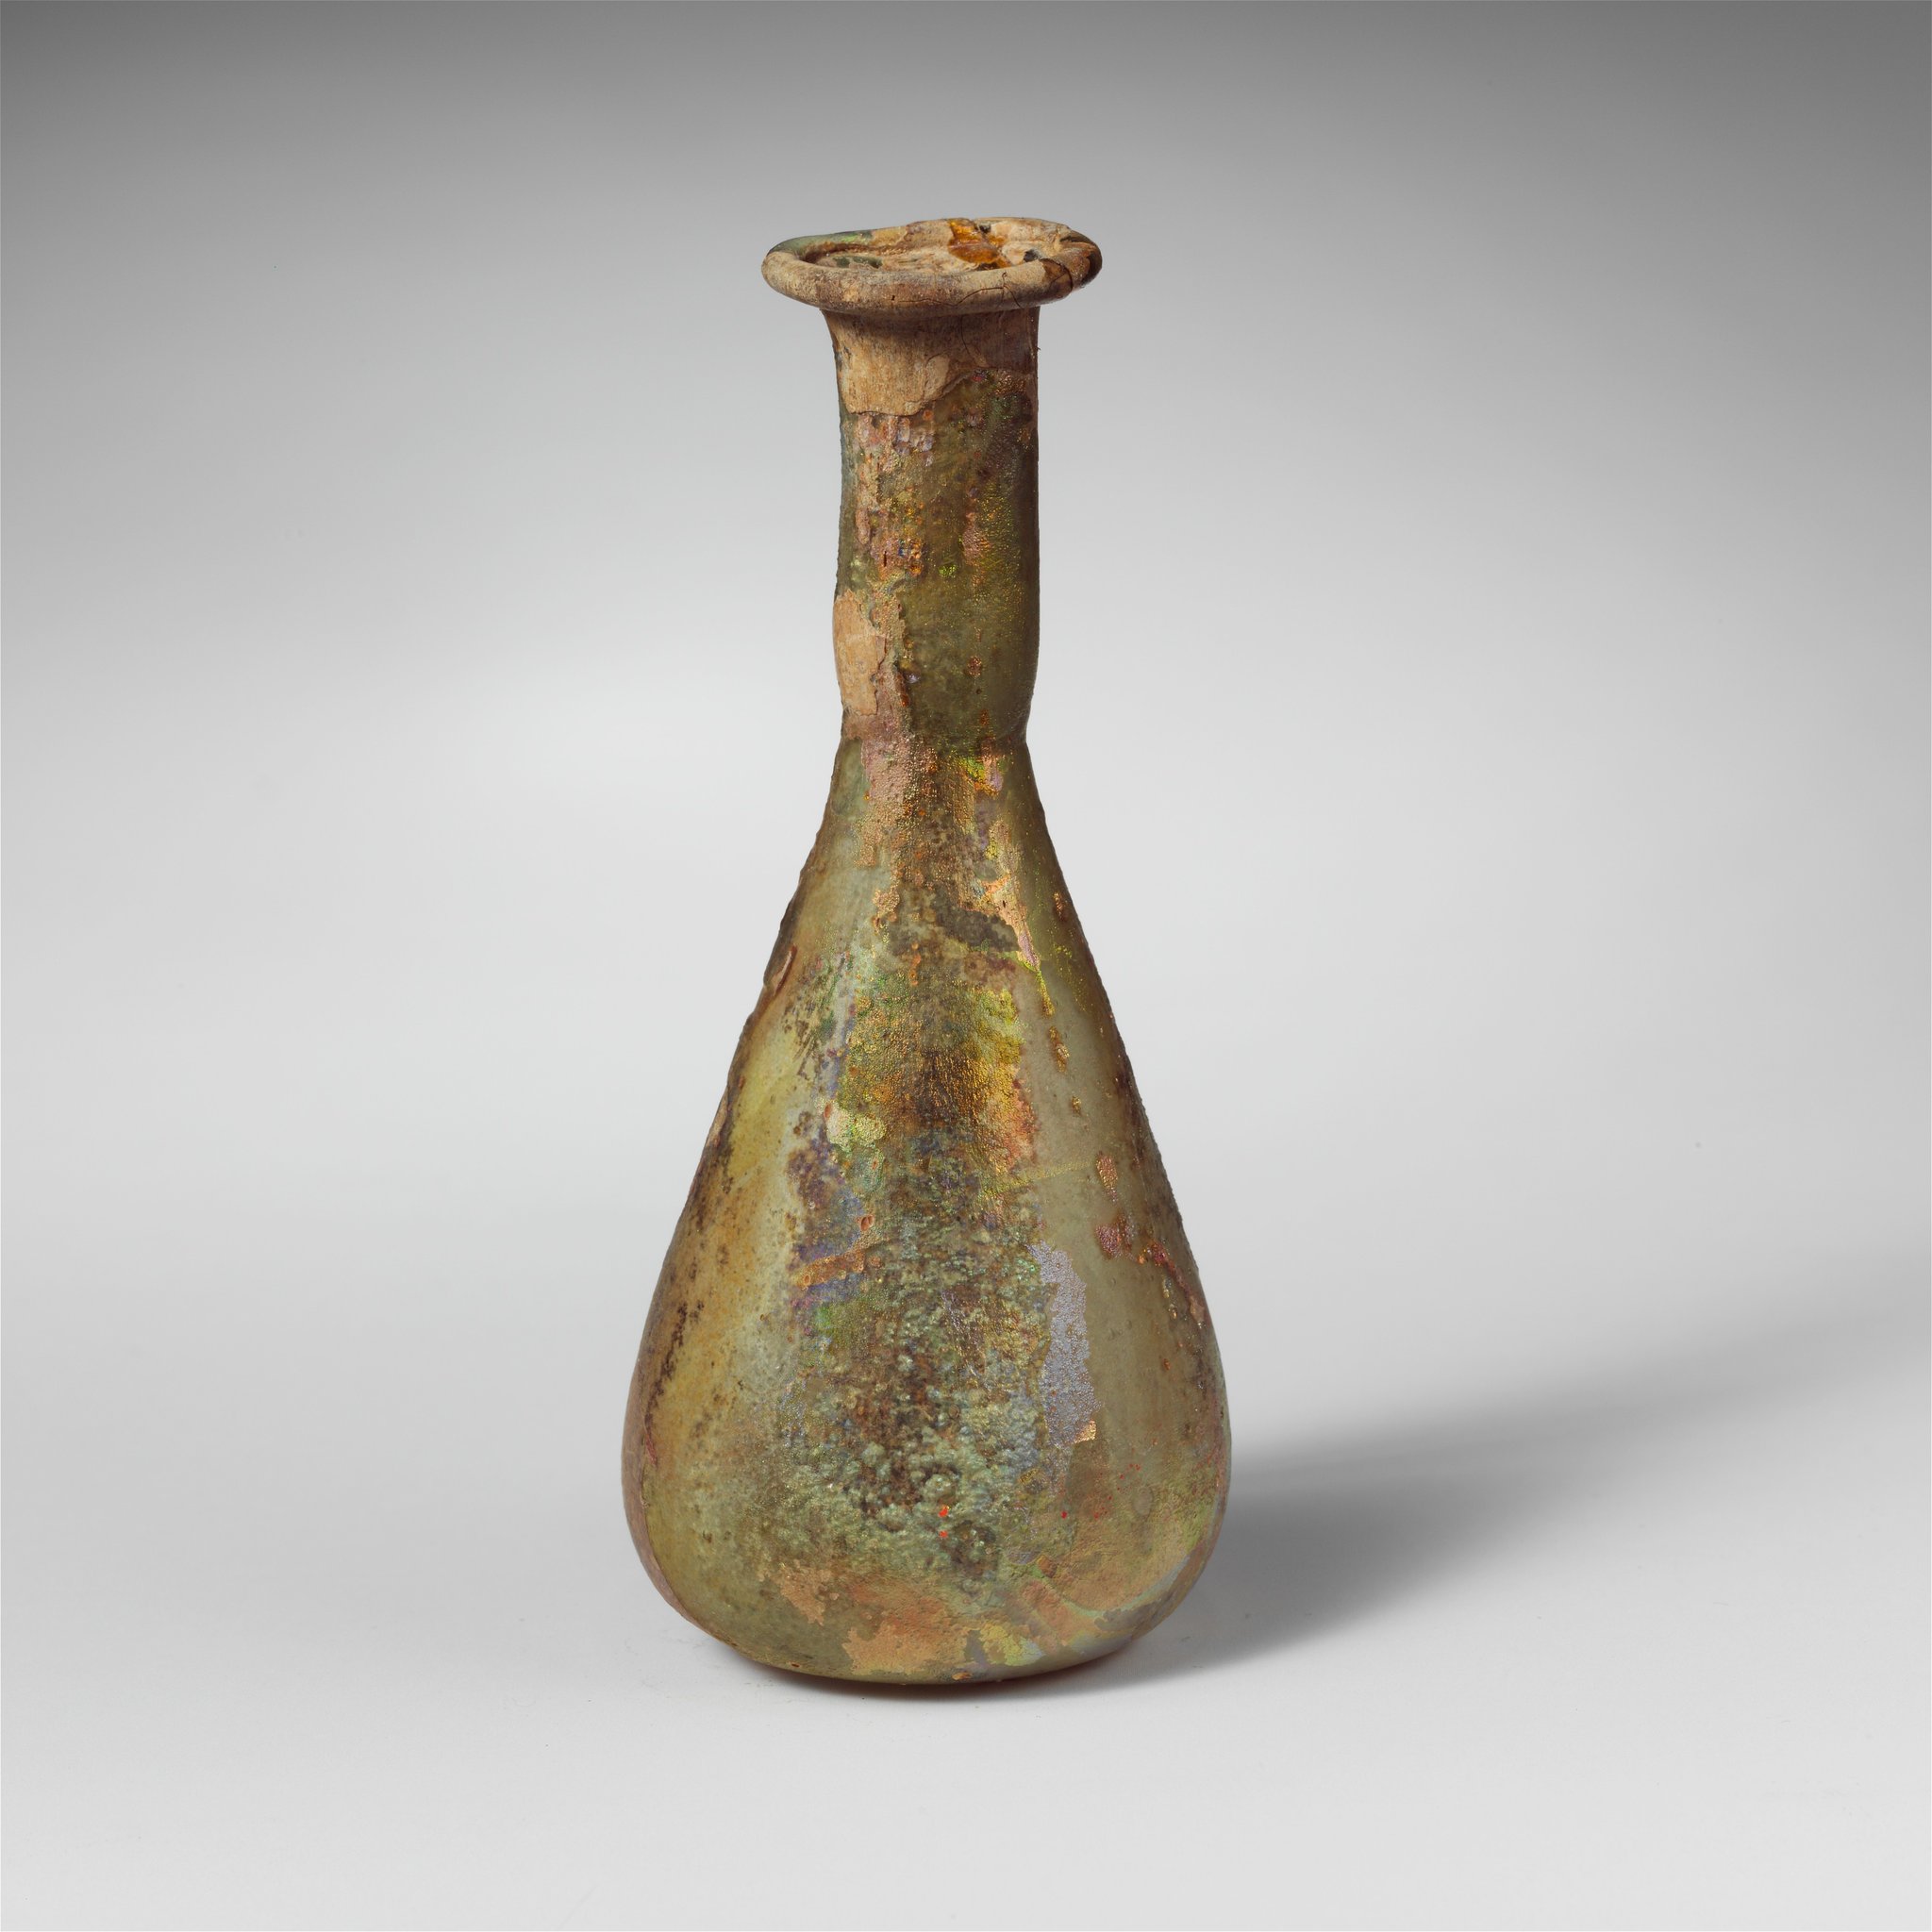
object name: perfume bottle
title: Glass perfume bottle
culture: roman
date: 1-100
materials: glass